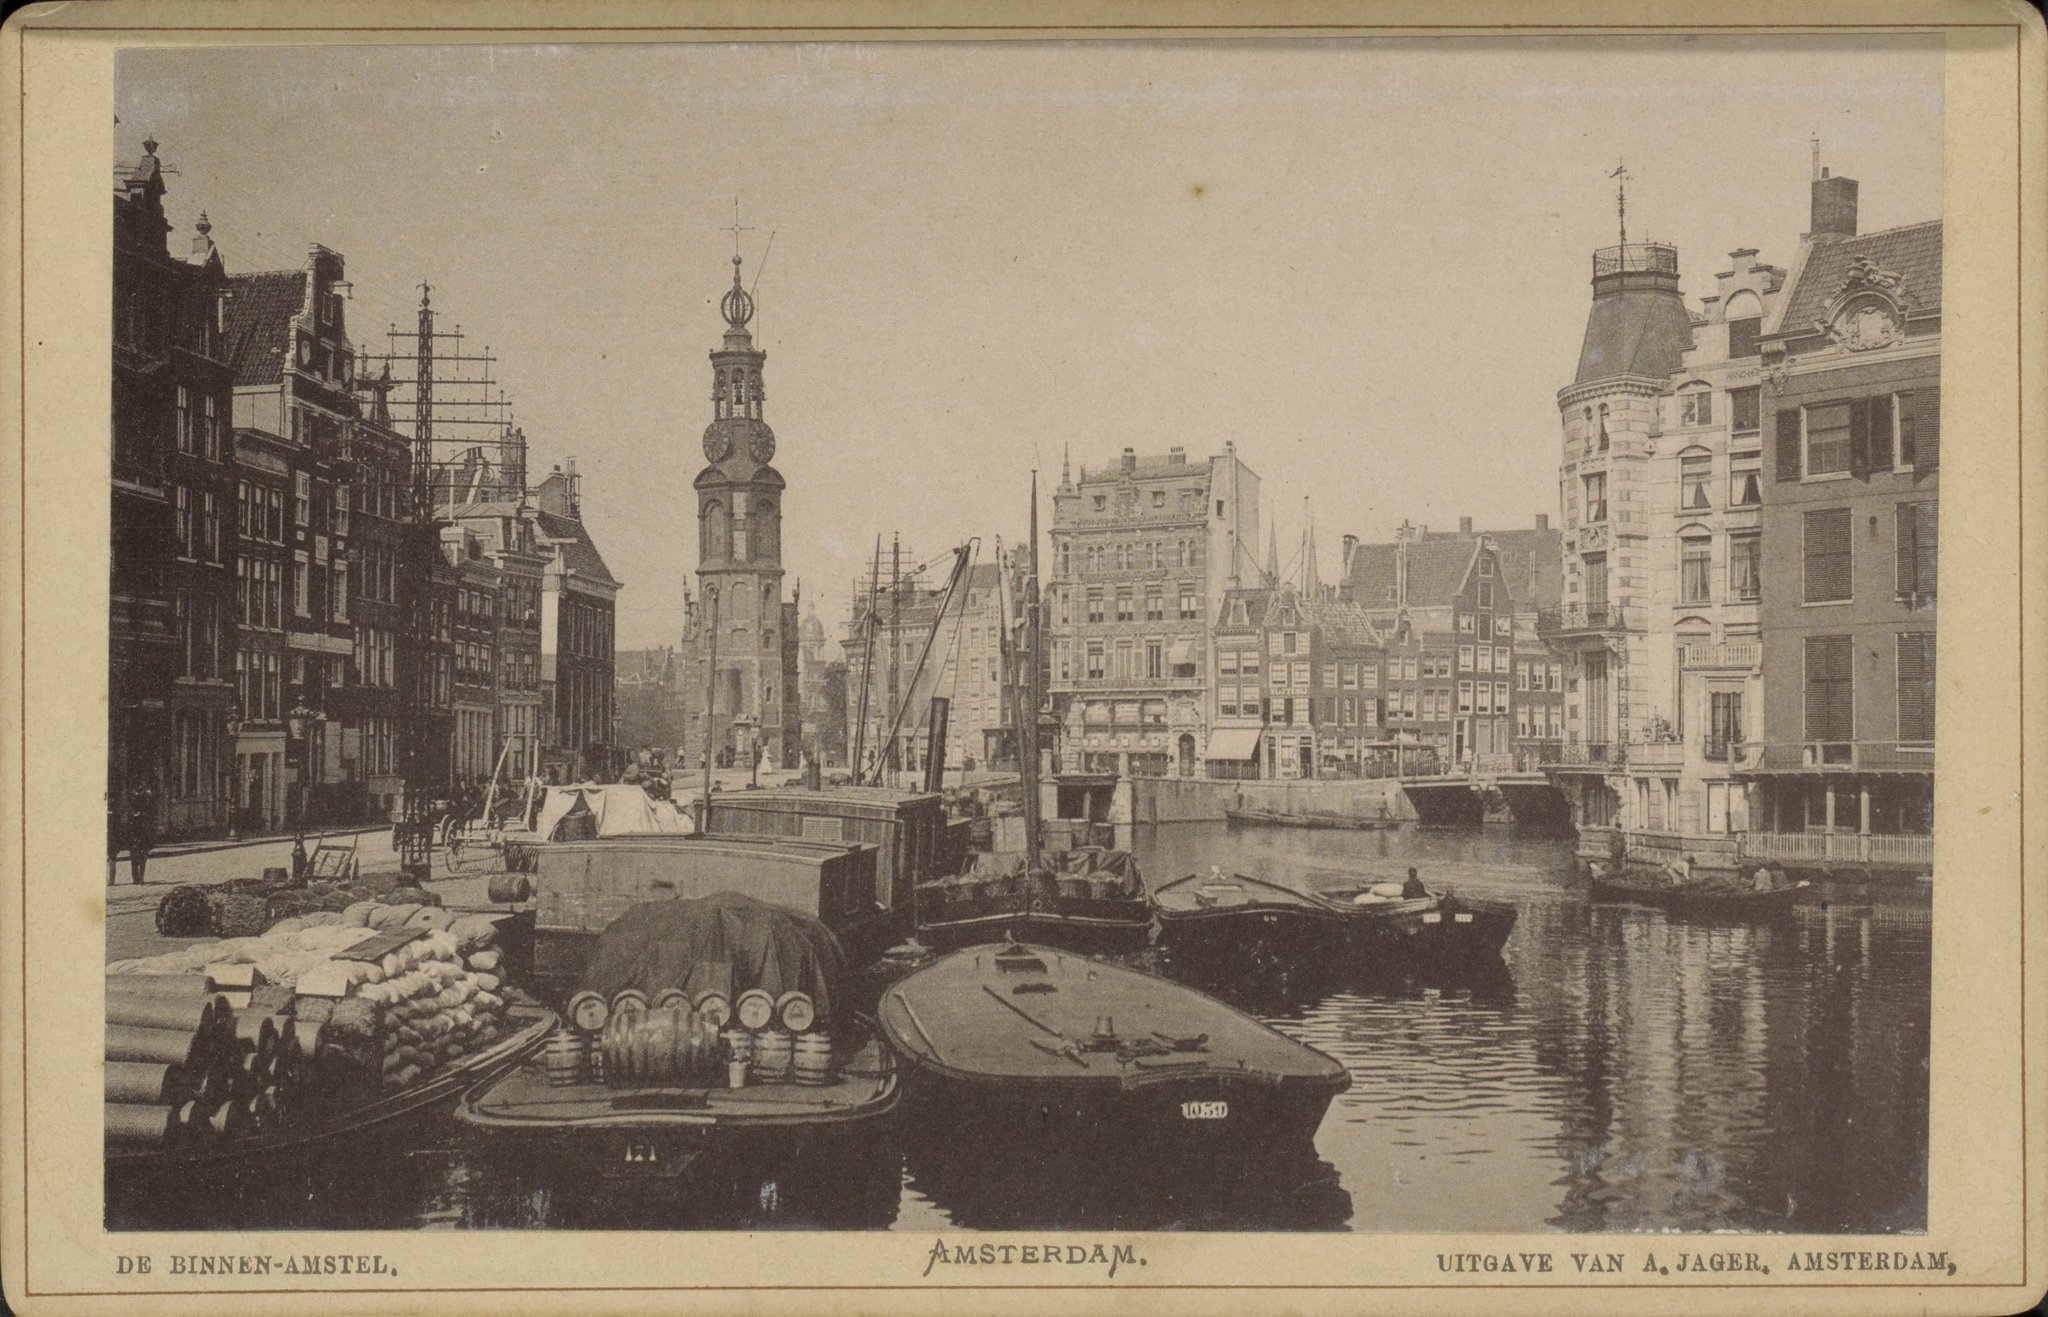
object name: photograph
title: Binnen-Amstel, gezien richting Munttoren, Amsterdam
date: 1880-1895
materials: cardboard, paper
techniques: photograph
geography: amsterdam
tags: binnen-amstel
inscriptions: inscription: ‘DE BINNEN-AMSTEL. AMSTERDAM. UITGAVE VAN A. JAGER, AMSTERDAM,’